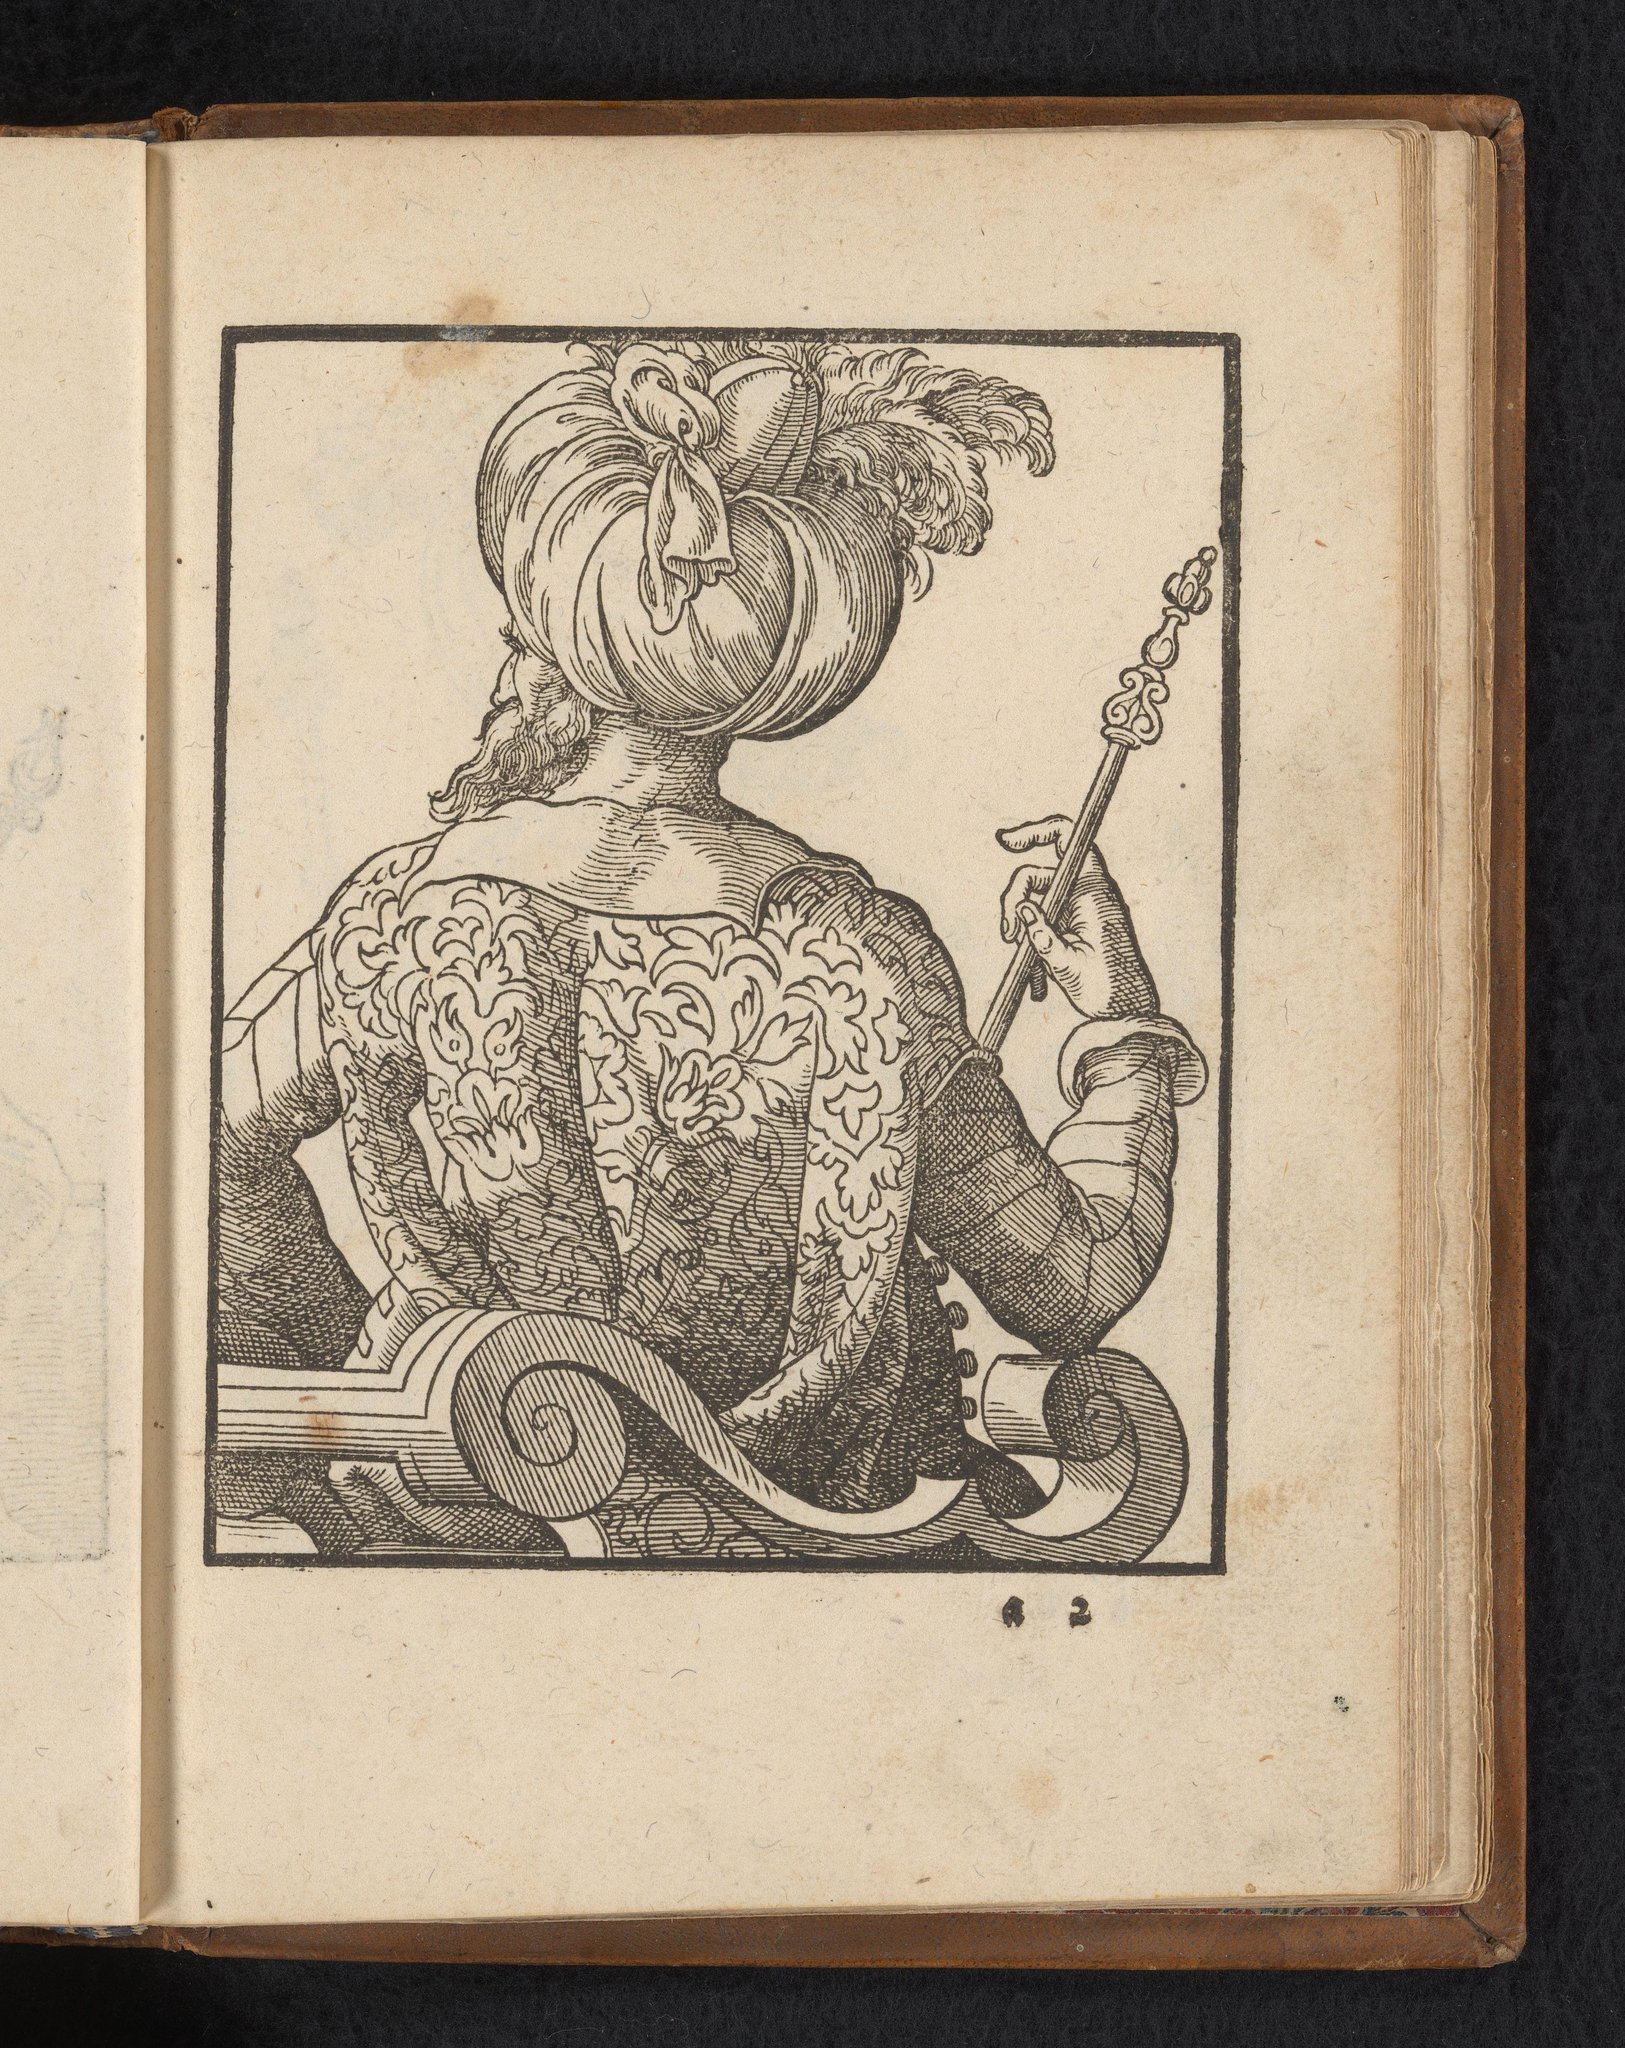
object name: print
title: Ottomaanse veldheer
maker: Anonymous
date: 1578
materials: paper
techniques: woodcut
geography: nuremberg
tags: asiatic races and peoples: turks, head-gear: turban, the soldier; the soldier's life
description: Een Ottomaanse veldheer, de rug gezien, op het hoofd een tulband met pluimen. Onderdeel van het modelboek Enchiridion artis pingendi, fingendi & sculpendi met 108 figuren bedoeld voor beginnende schilders, beeldhouwers en prentmakers.